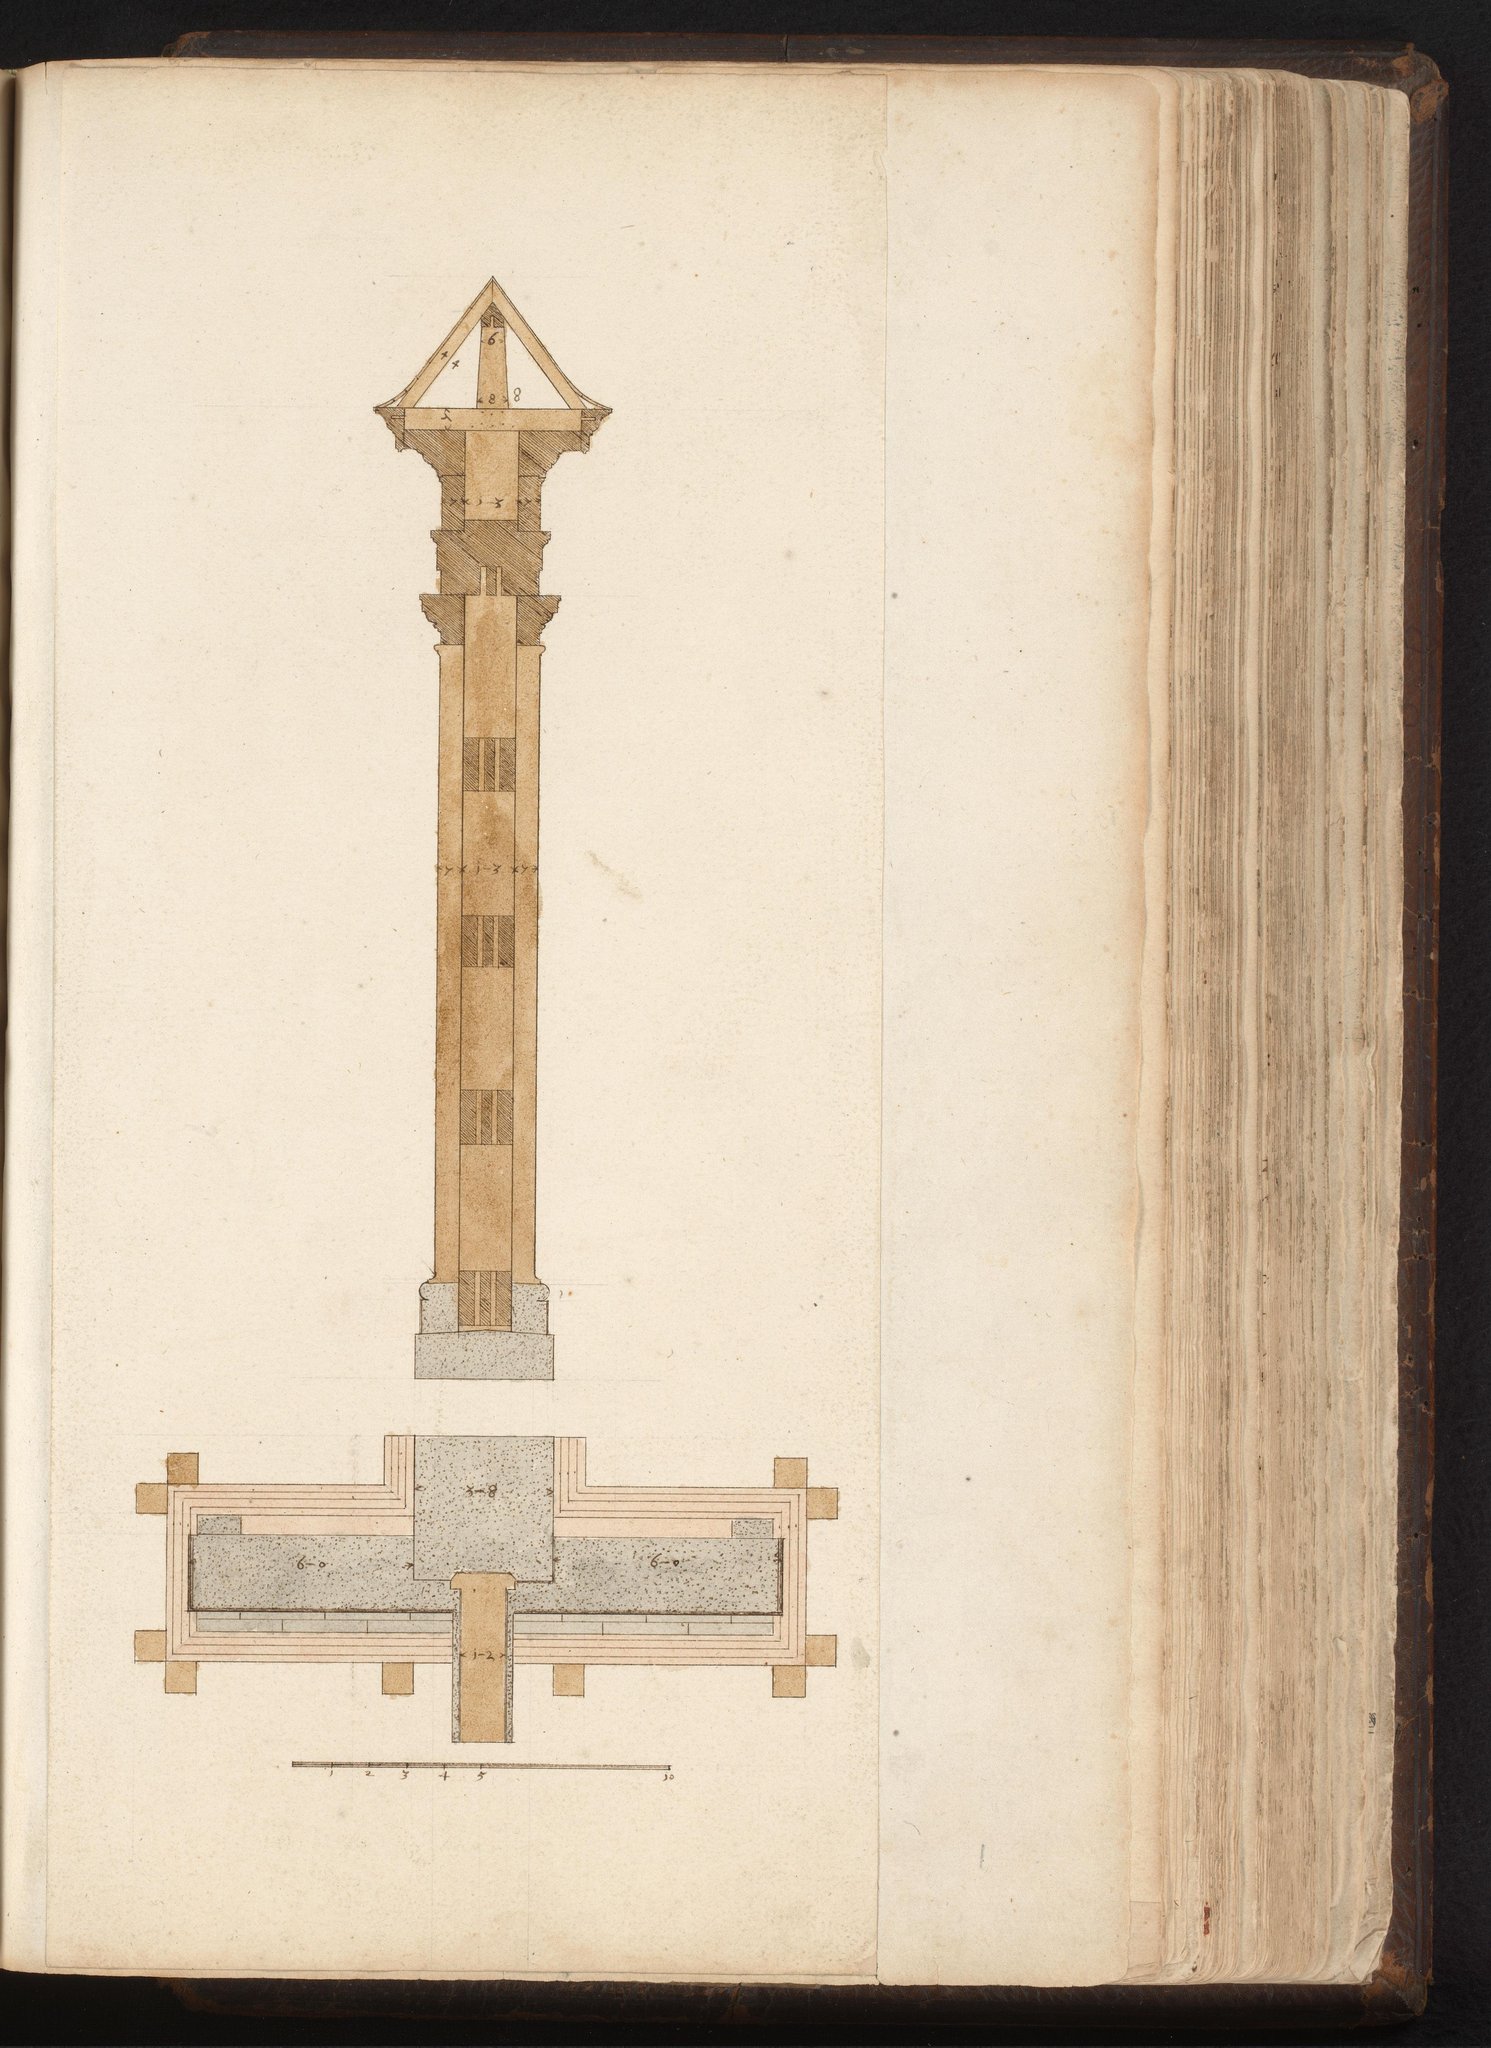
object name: drawing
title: Bouwkundige doorsnede van een fundering en muur of zuil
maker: Anonymous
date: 1650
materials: ink, paper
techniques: brush, pen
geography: amsterdam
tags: building activities, section ~ architectural design or model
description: Bouwkundige doorsnede van een fundering en een muur of zuil, met afmetingen. Met onderaan een schaalaanduiding. Tekening maakt deel uit van een album.